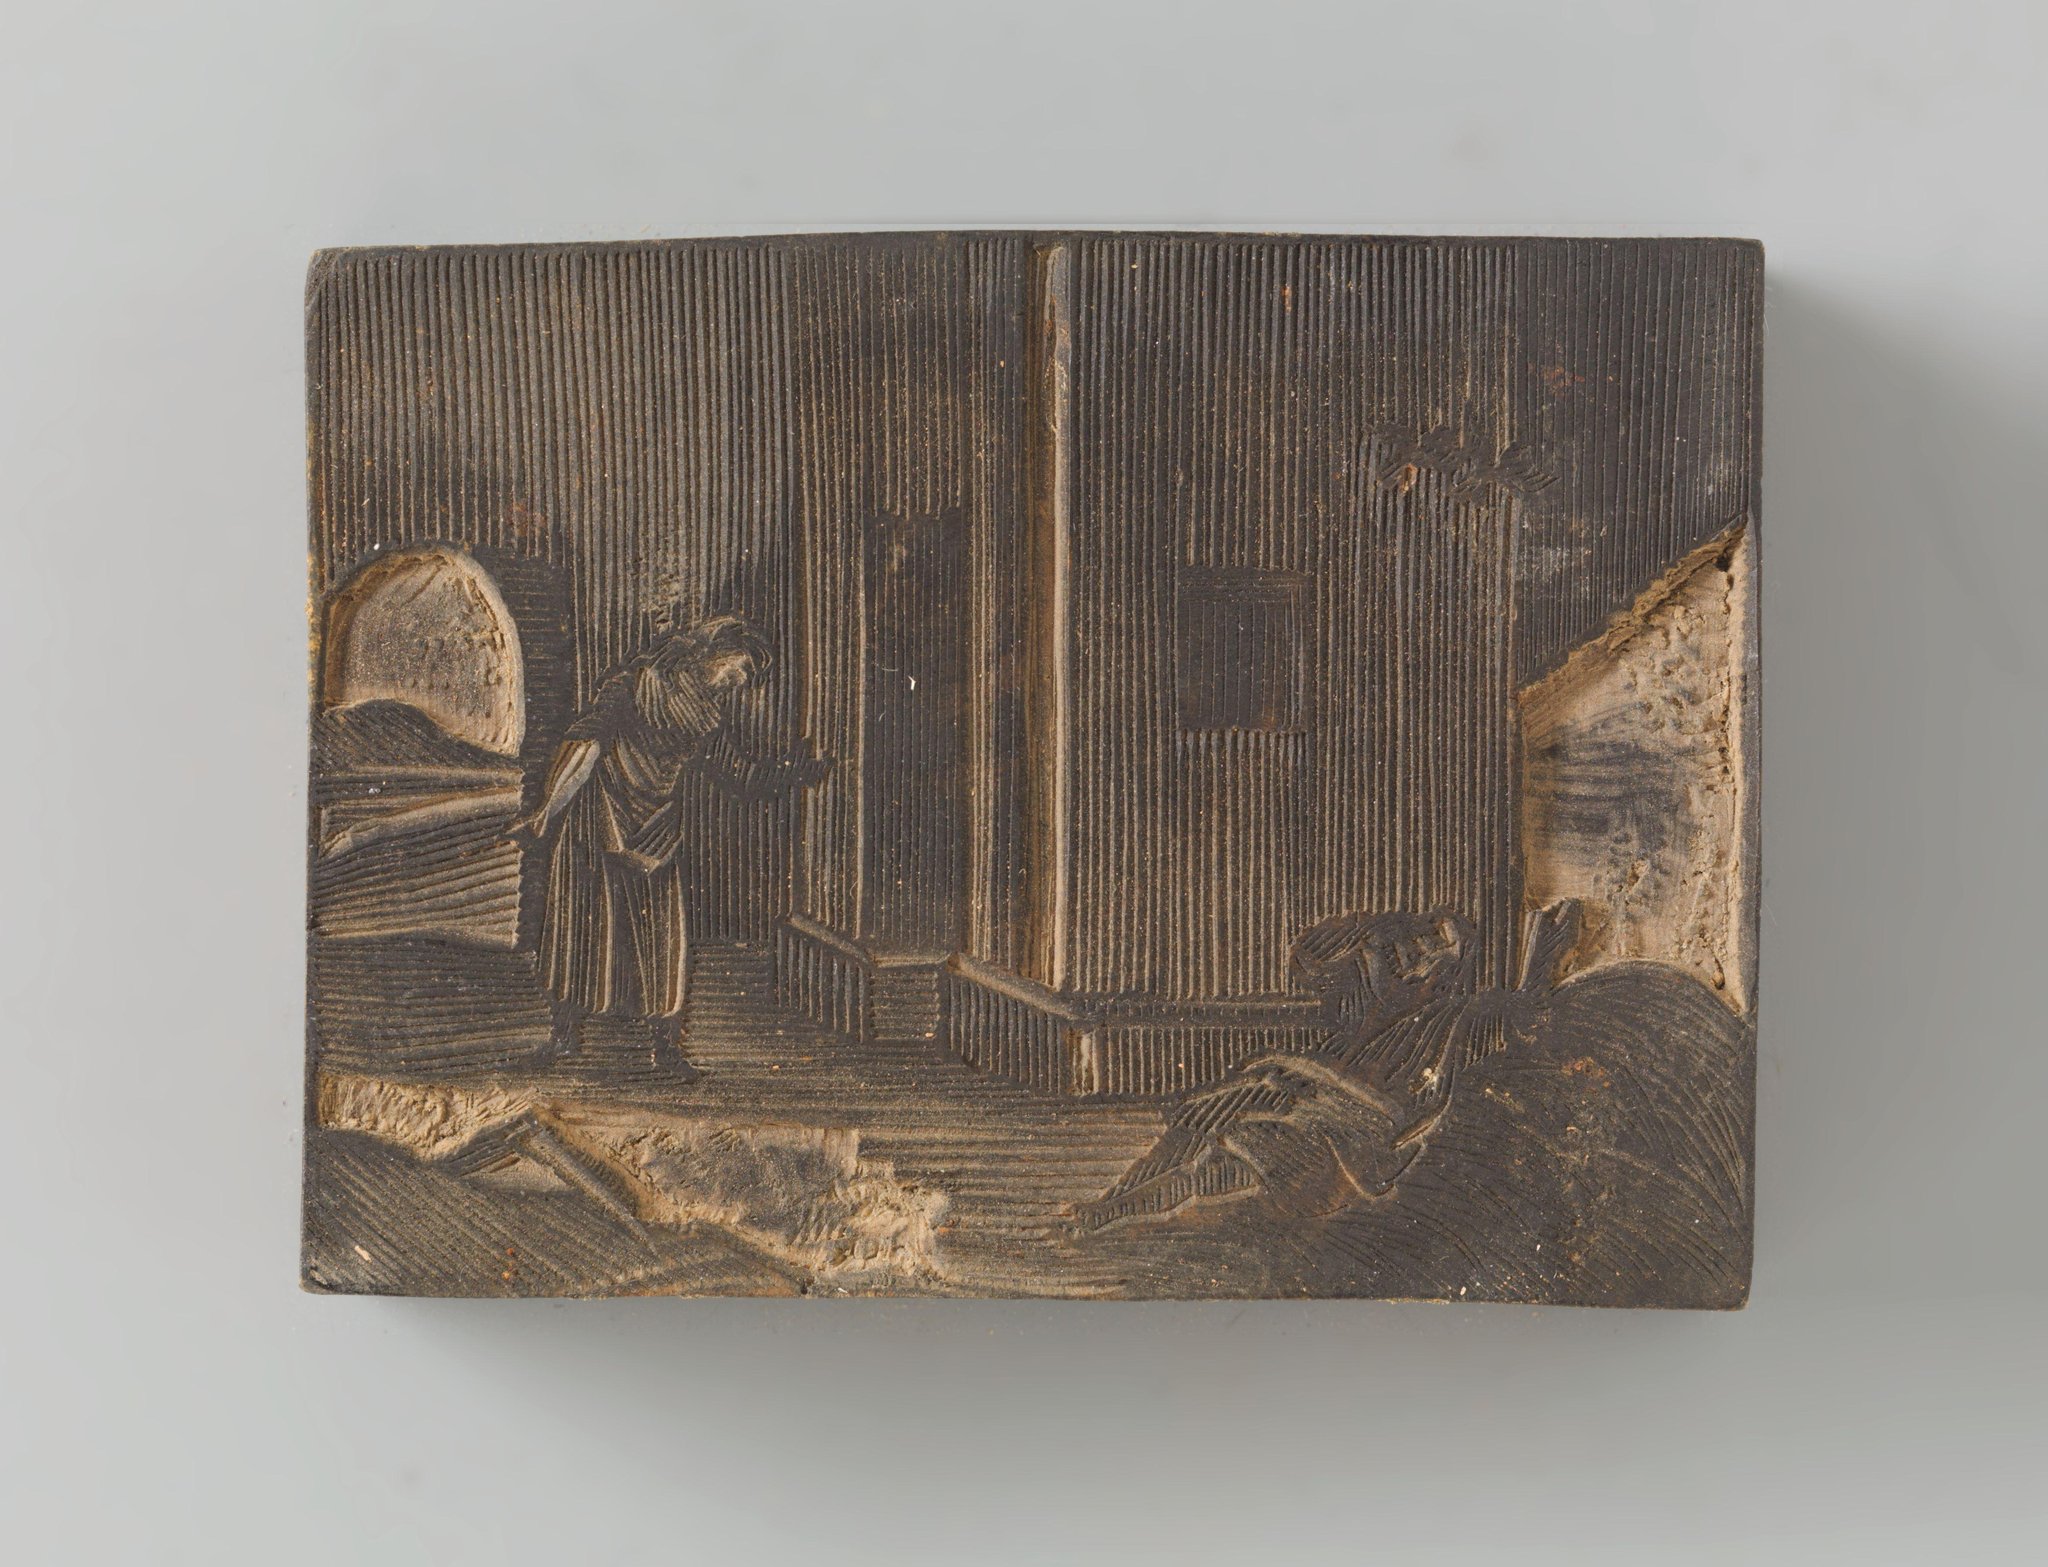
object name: wood block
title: Bijbel-illustraties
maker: Anonymous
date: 1550-1699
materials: wood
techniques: woodcut